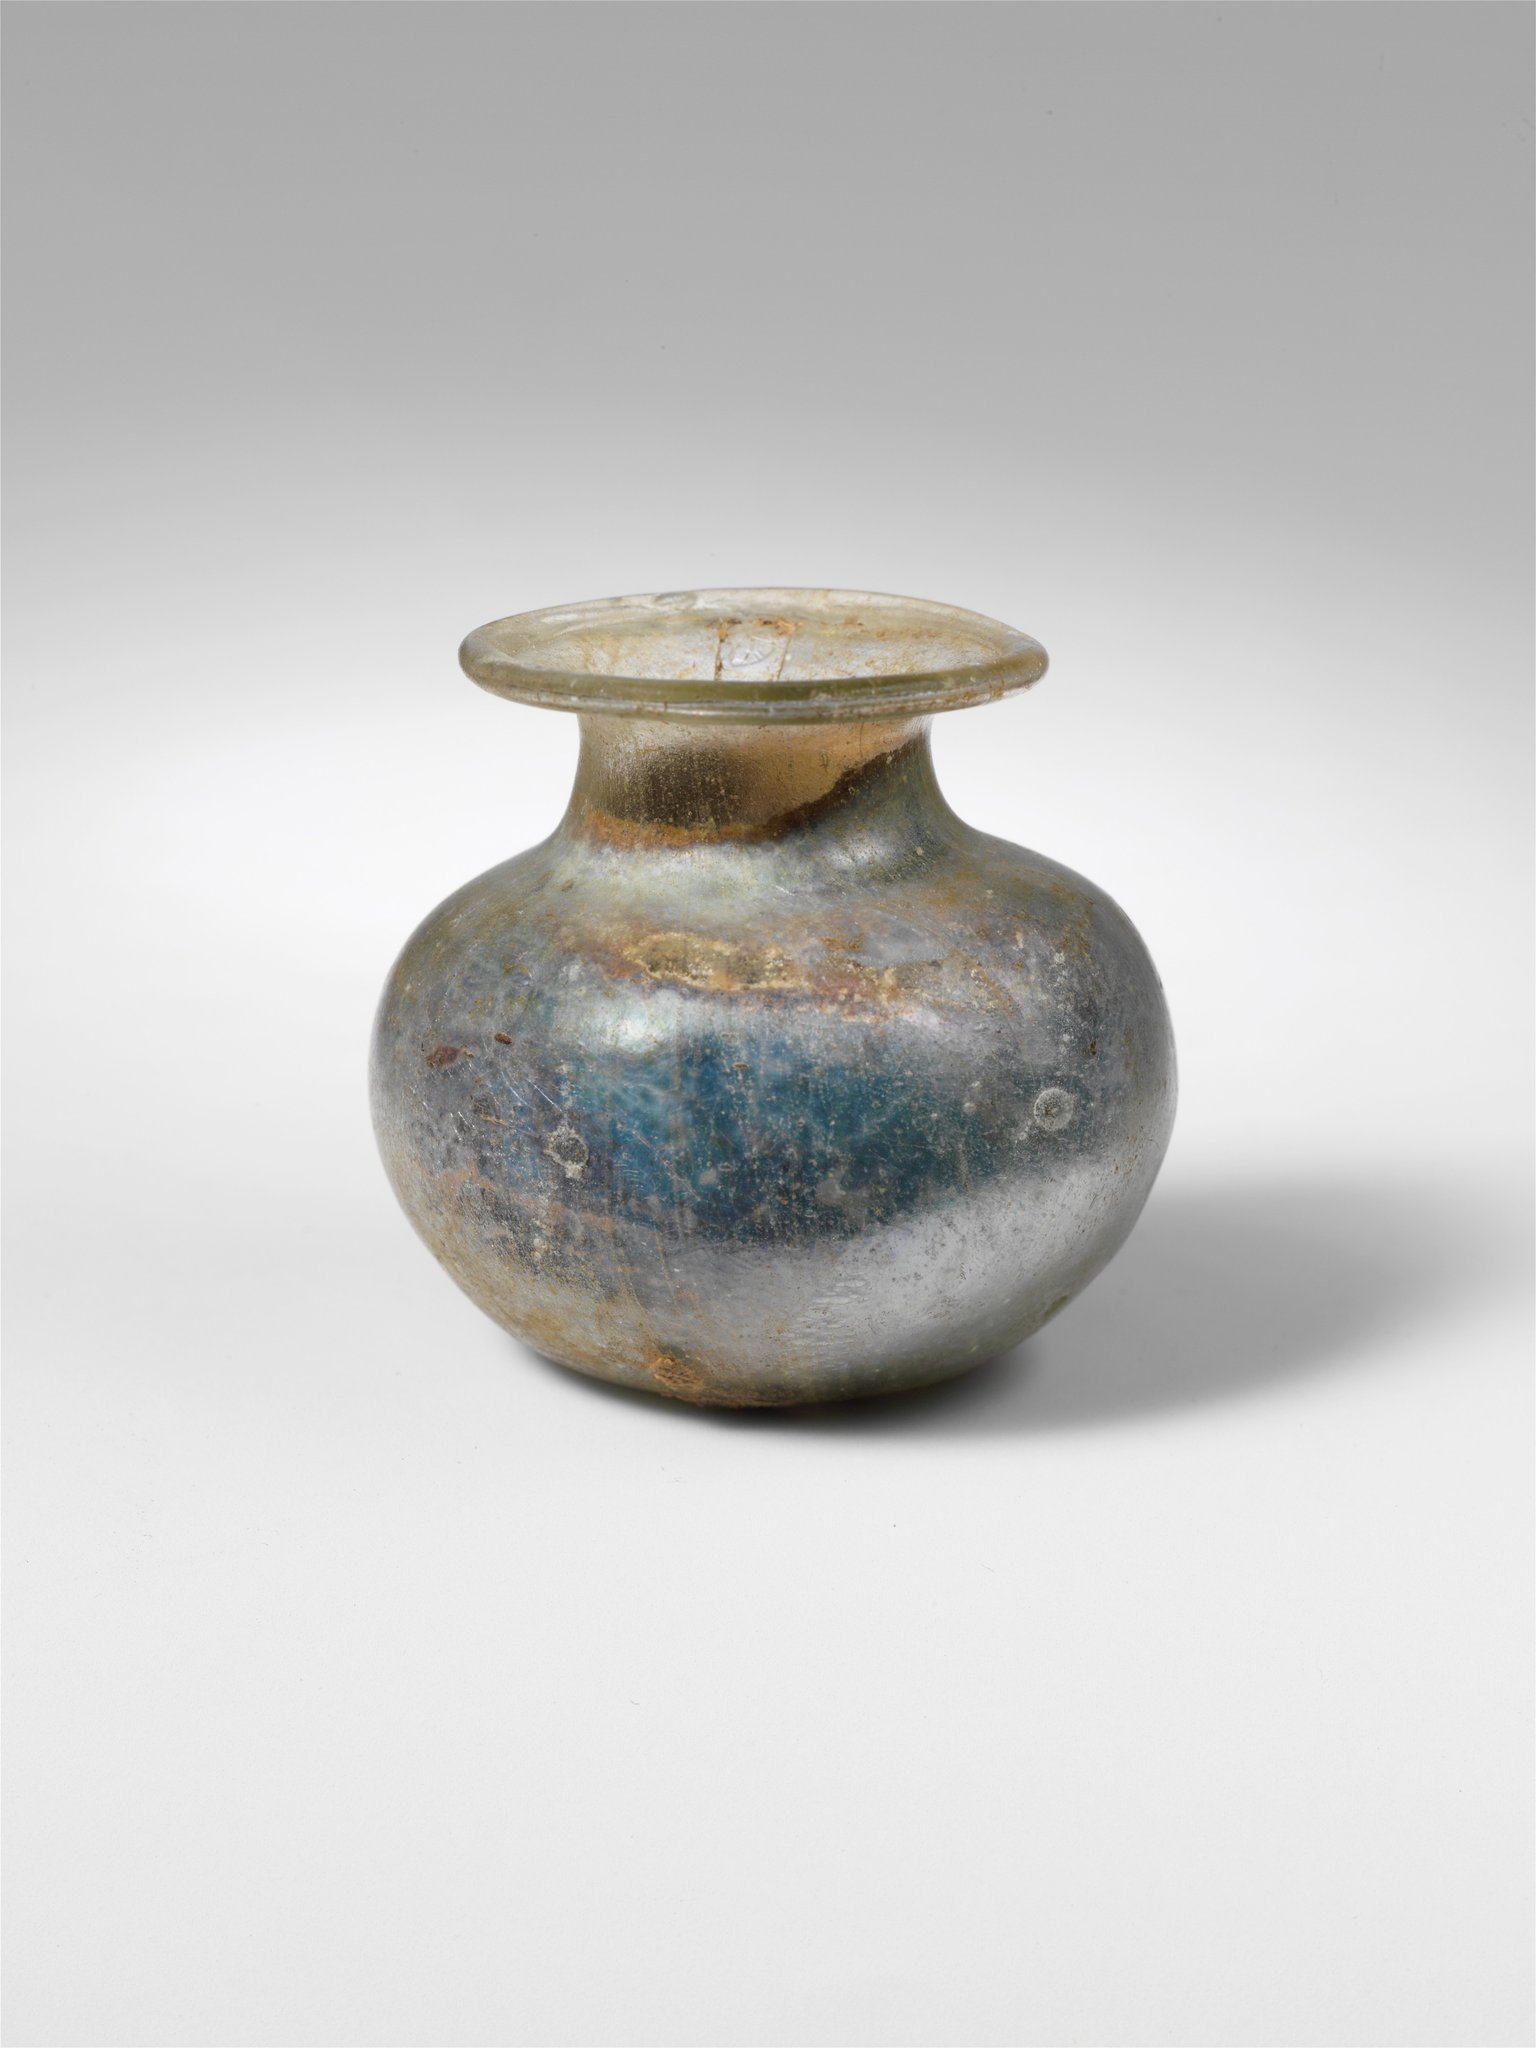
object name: jar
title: Glass jar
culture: roman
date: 100 BCE-500 CE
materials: glass